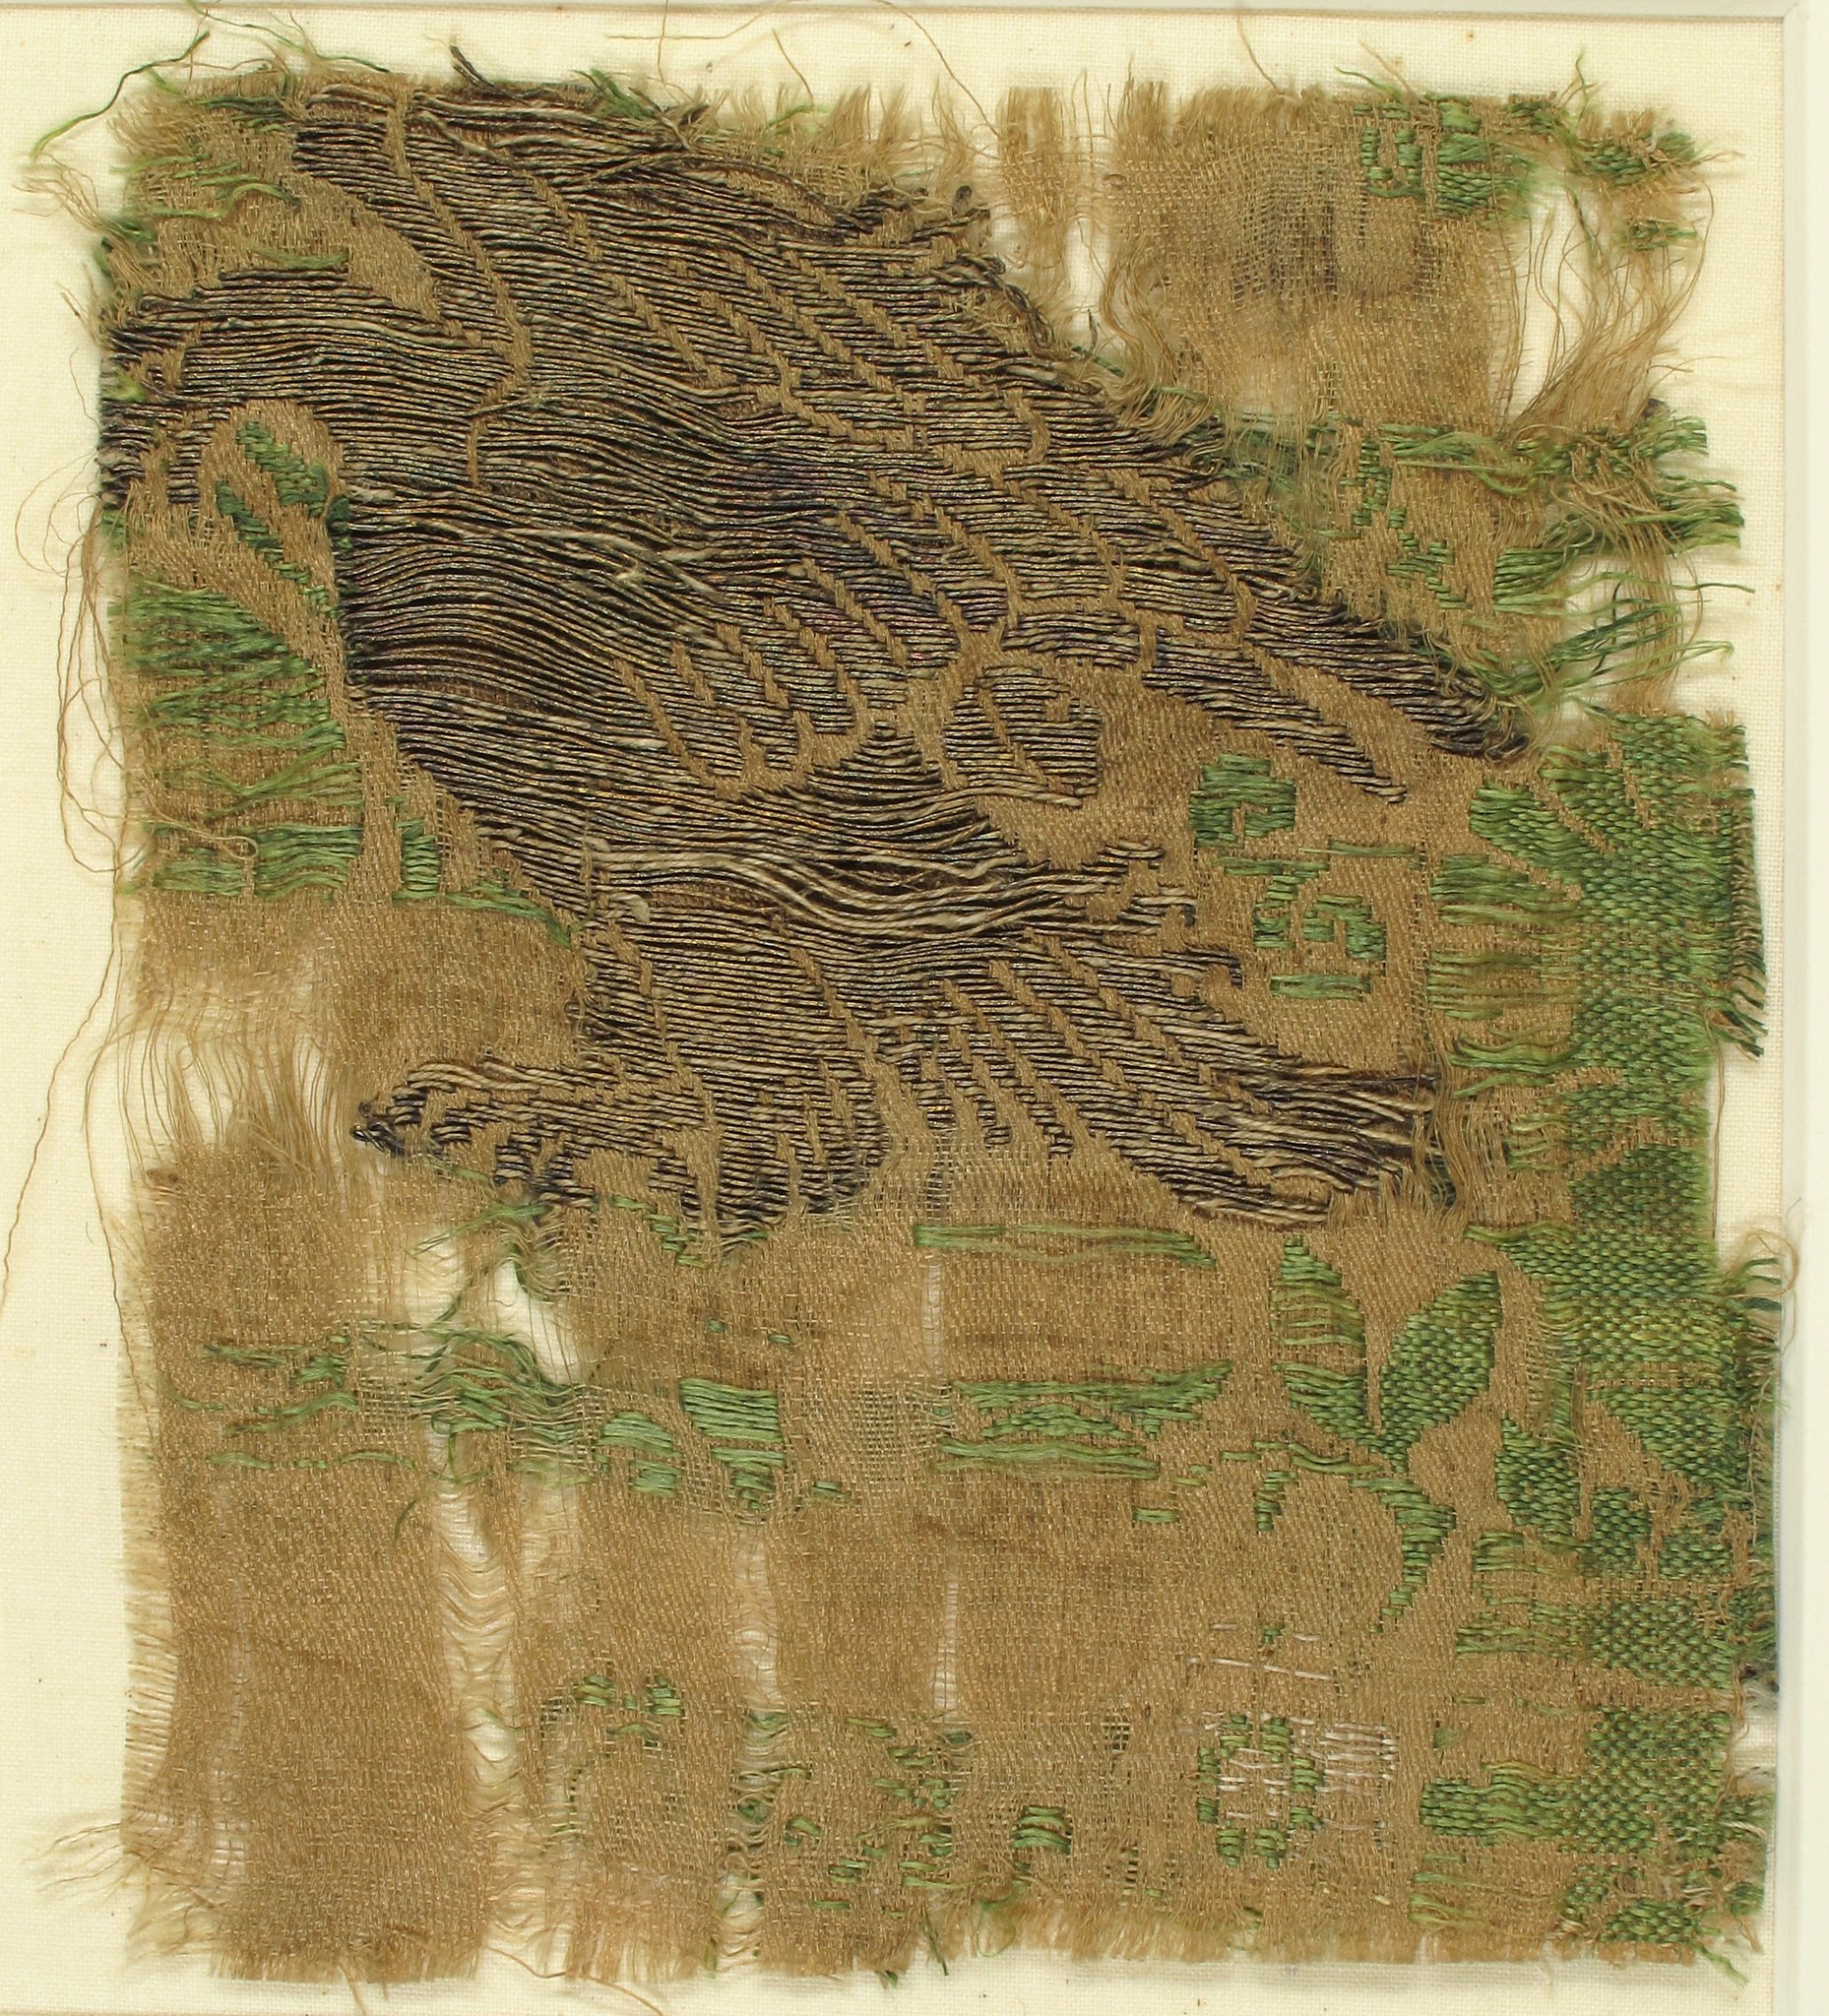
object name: textile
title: Textile with Brocade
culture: italo-arabic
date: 1301-1400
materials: gold thread, silk